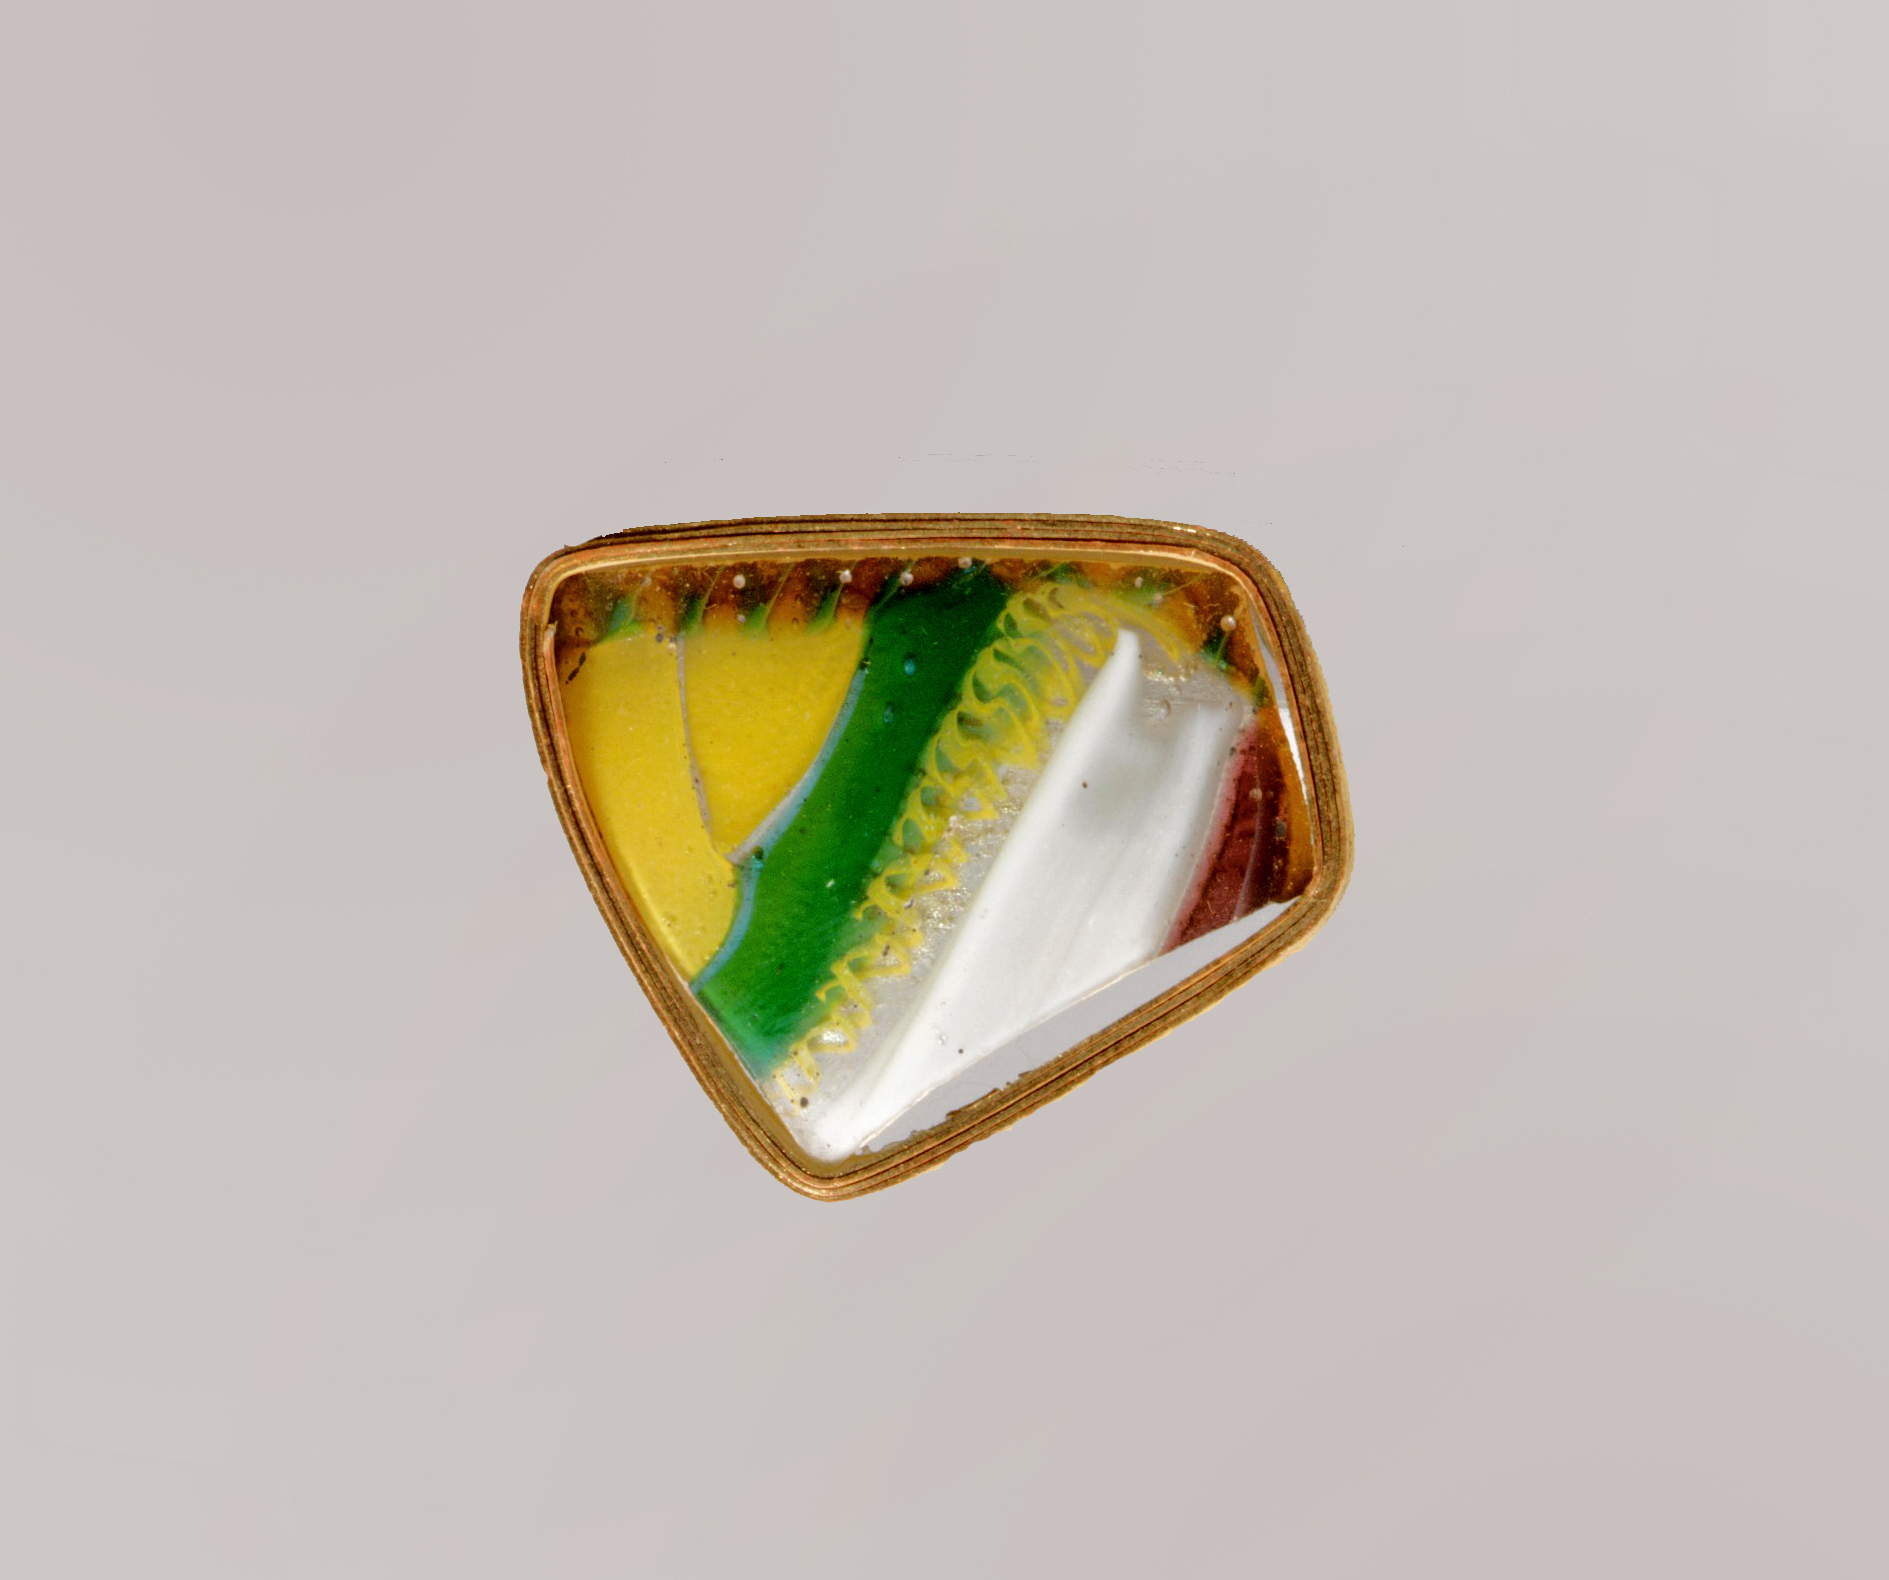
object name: fragment, striped mosaic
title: Glass striped mosaic bowl fragment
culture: roman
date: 34 BCE-33 CE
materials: glass